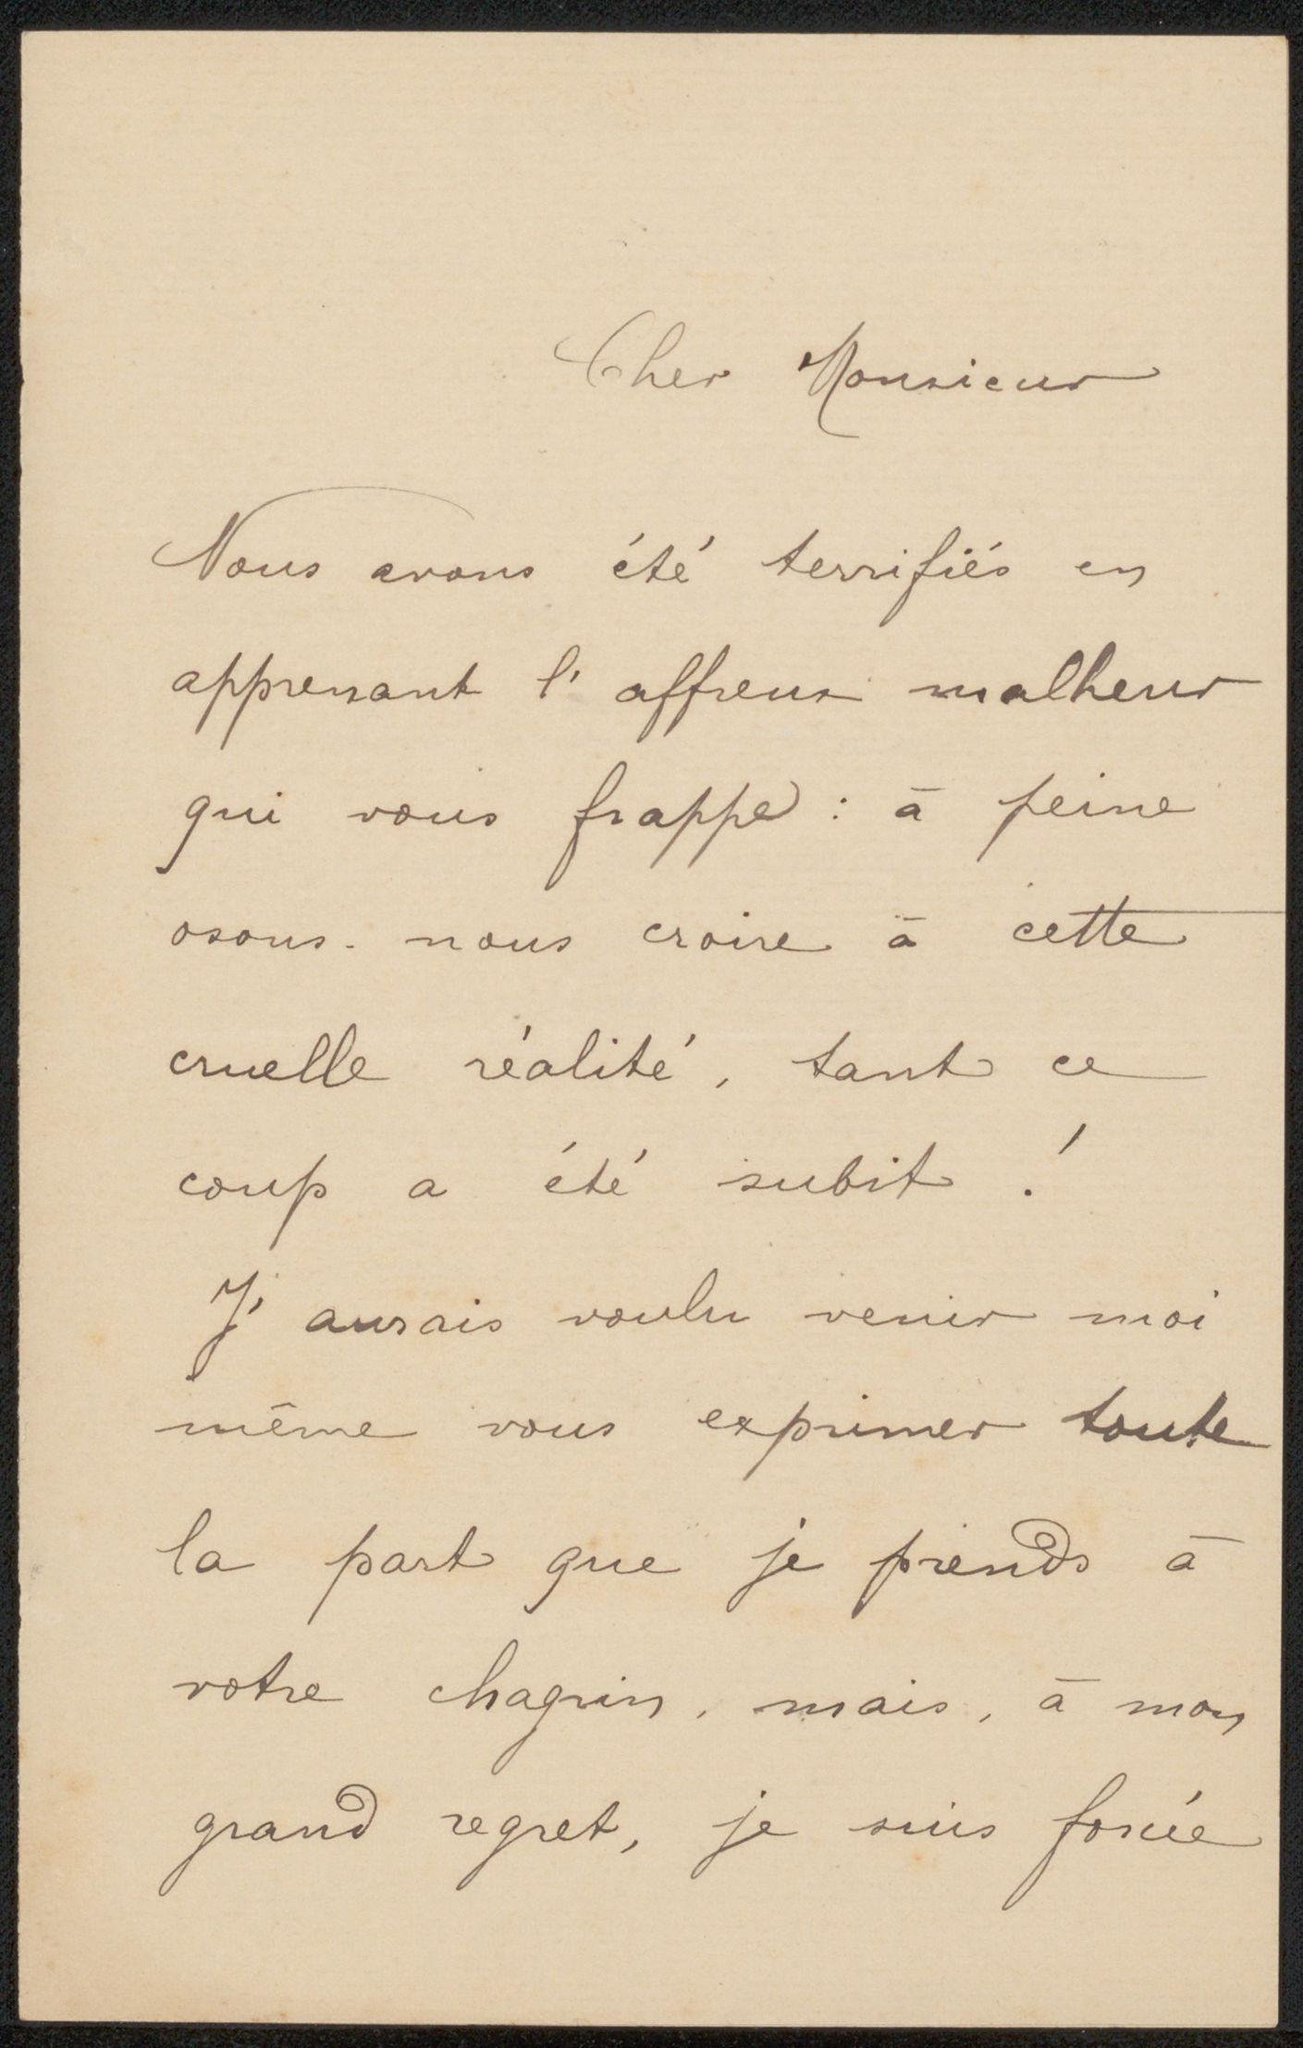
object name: letter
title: Brief aan Philip Zilcken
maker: marguerite picard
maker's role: zangeres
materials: ink, paper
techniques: pen, writing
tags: brussels, helène lambertine hauzeur, the hague, painter, draughtsman, philip zilcken, passions, emotions, affections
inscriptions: watermark